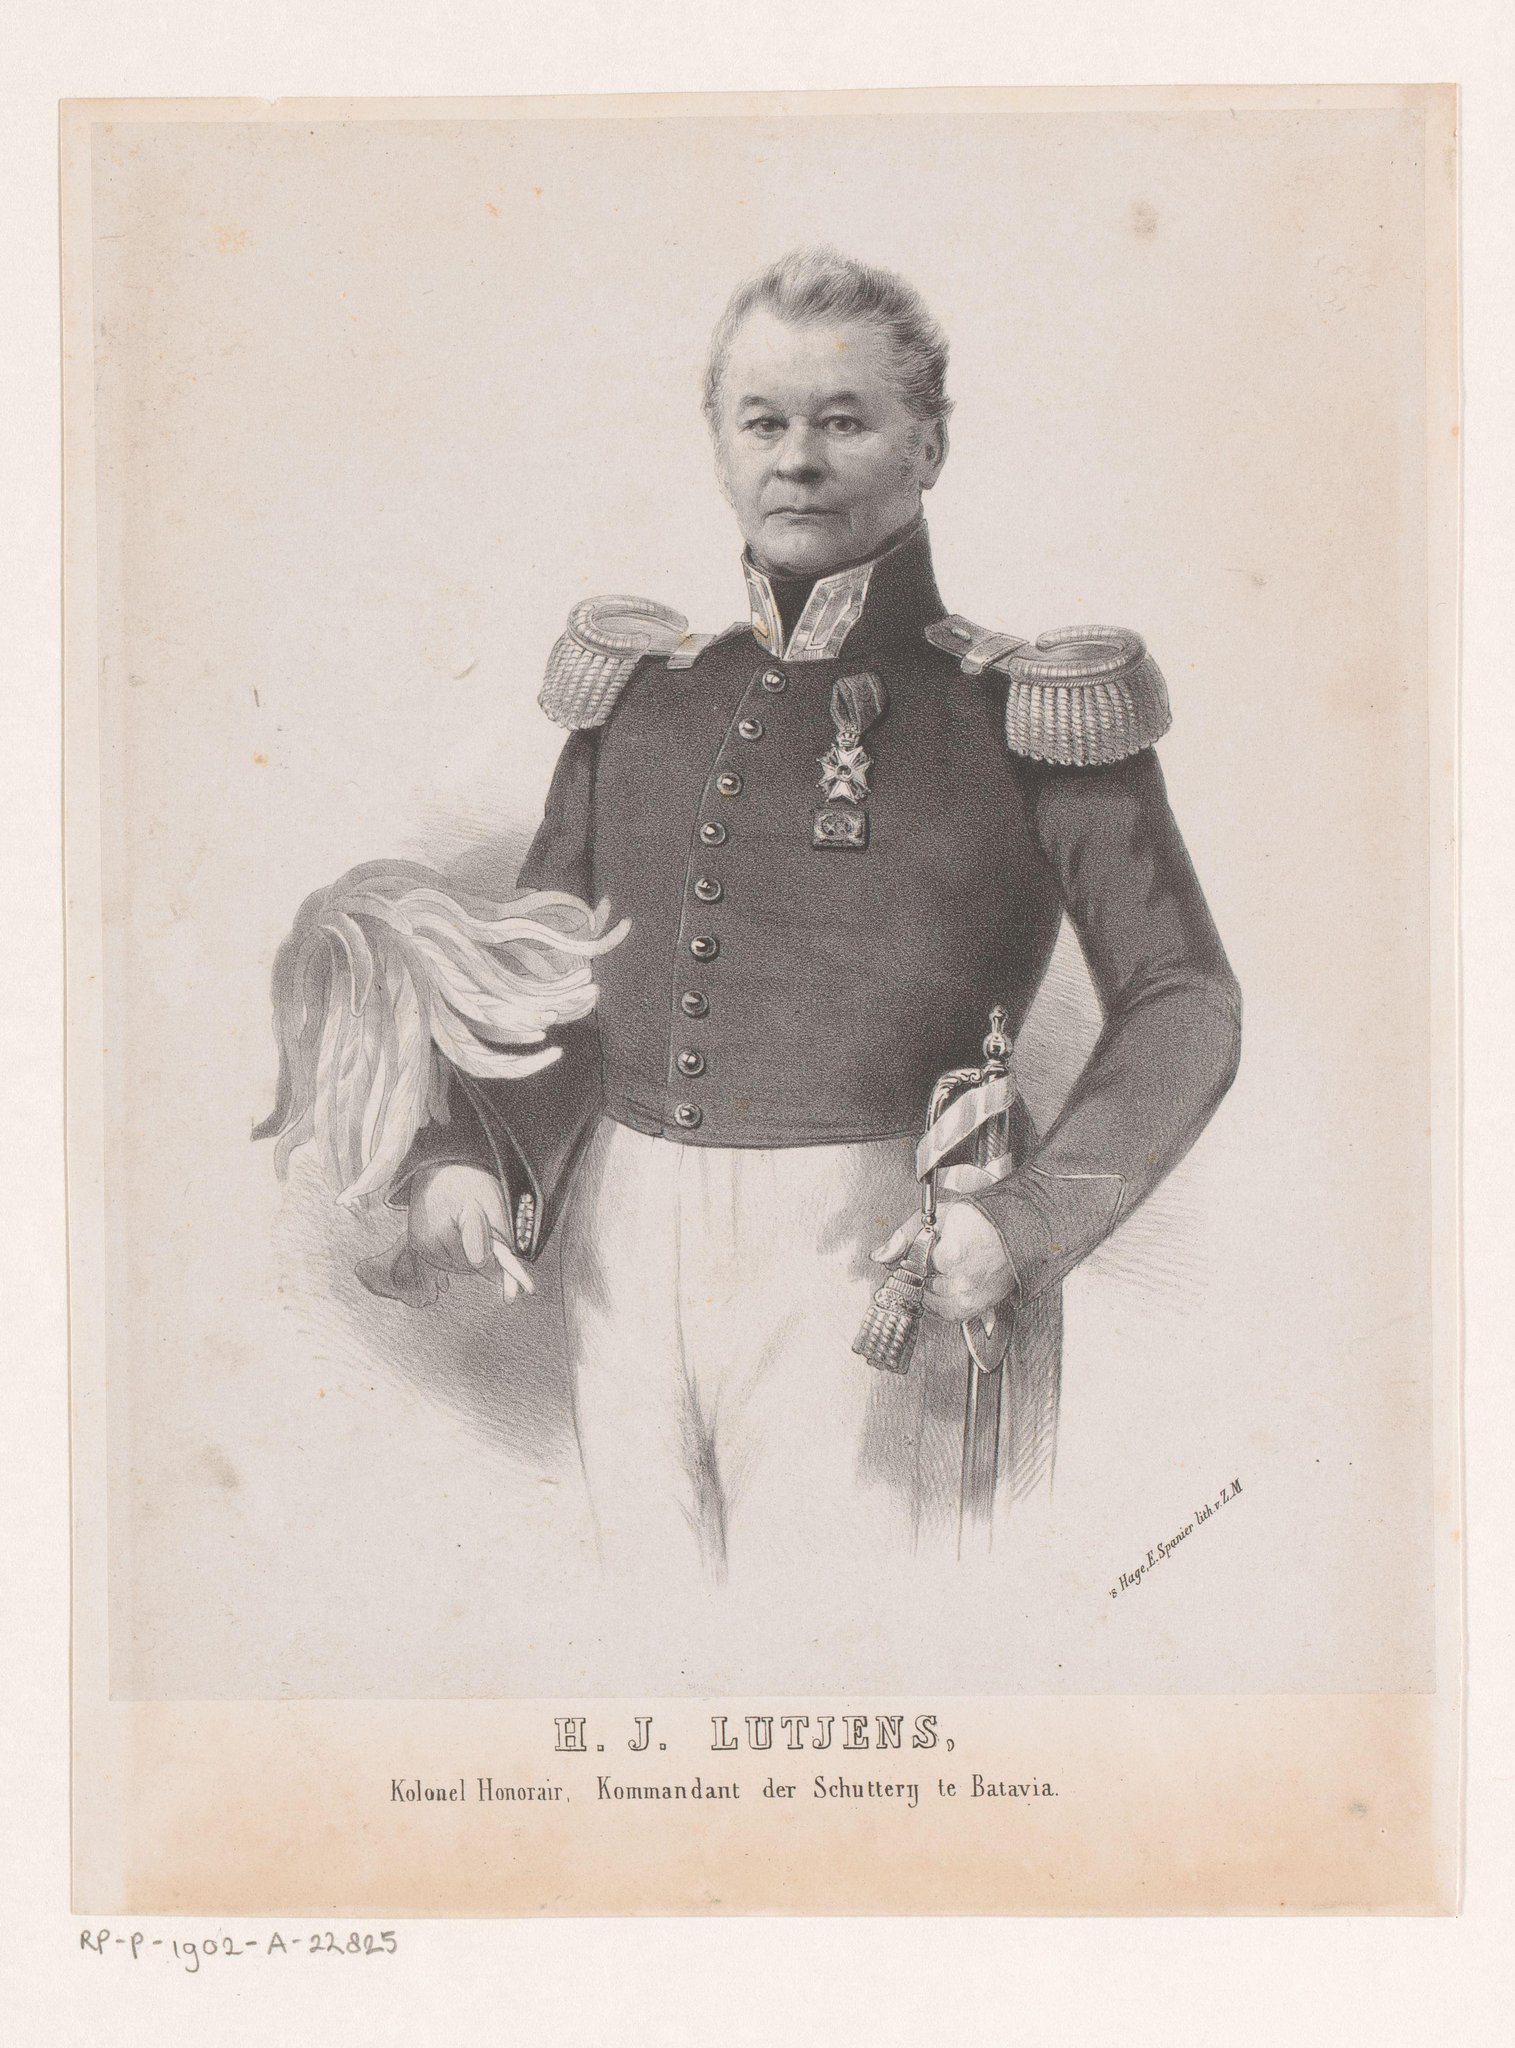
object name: print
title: Portret van H.J. Lutjens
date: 1849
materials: paper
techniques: lithograph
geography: the hague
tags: head-gear: bicorne, bicorn, knighthood order, historical persons (+ three-quarter length portrait)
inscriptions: collector's mark: Lugt 2228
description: De geportretteerde draagt een militair kostuum met ordetekenen en een sabel. Hij draagt de steek met pluim onder zijn rechterarm.